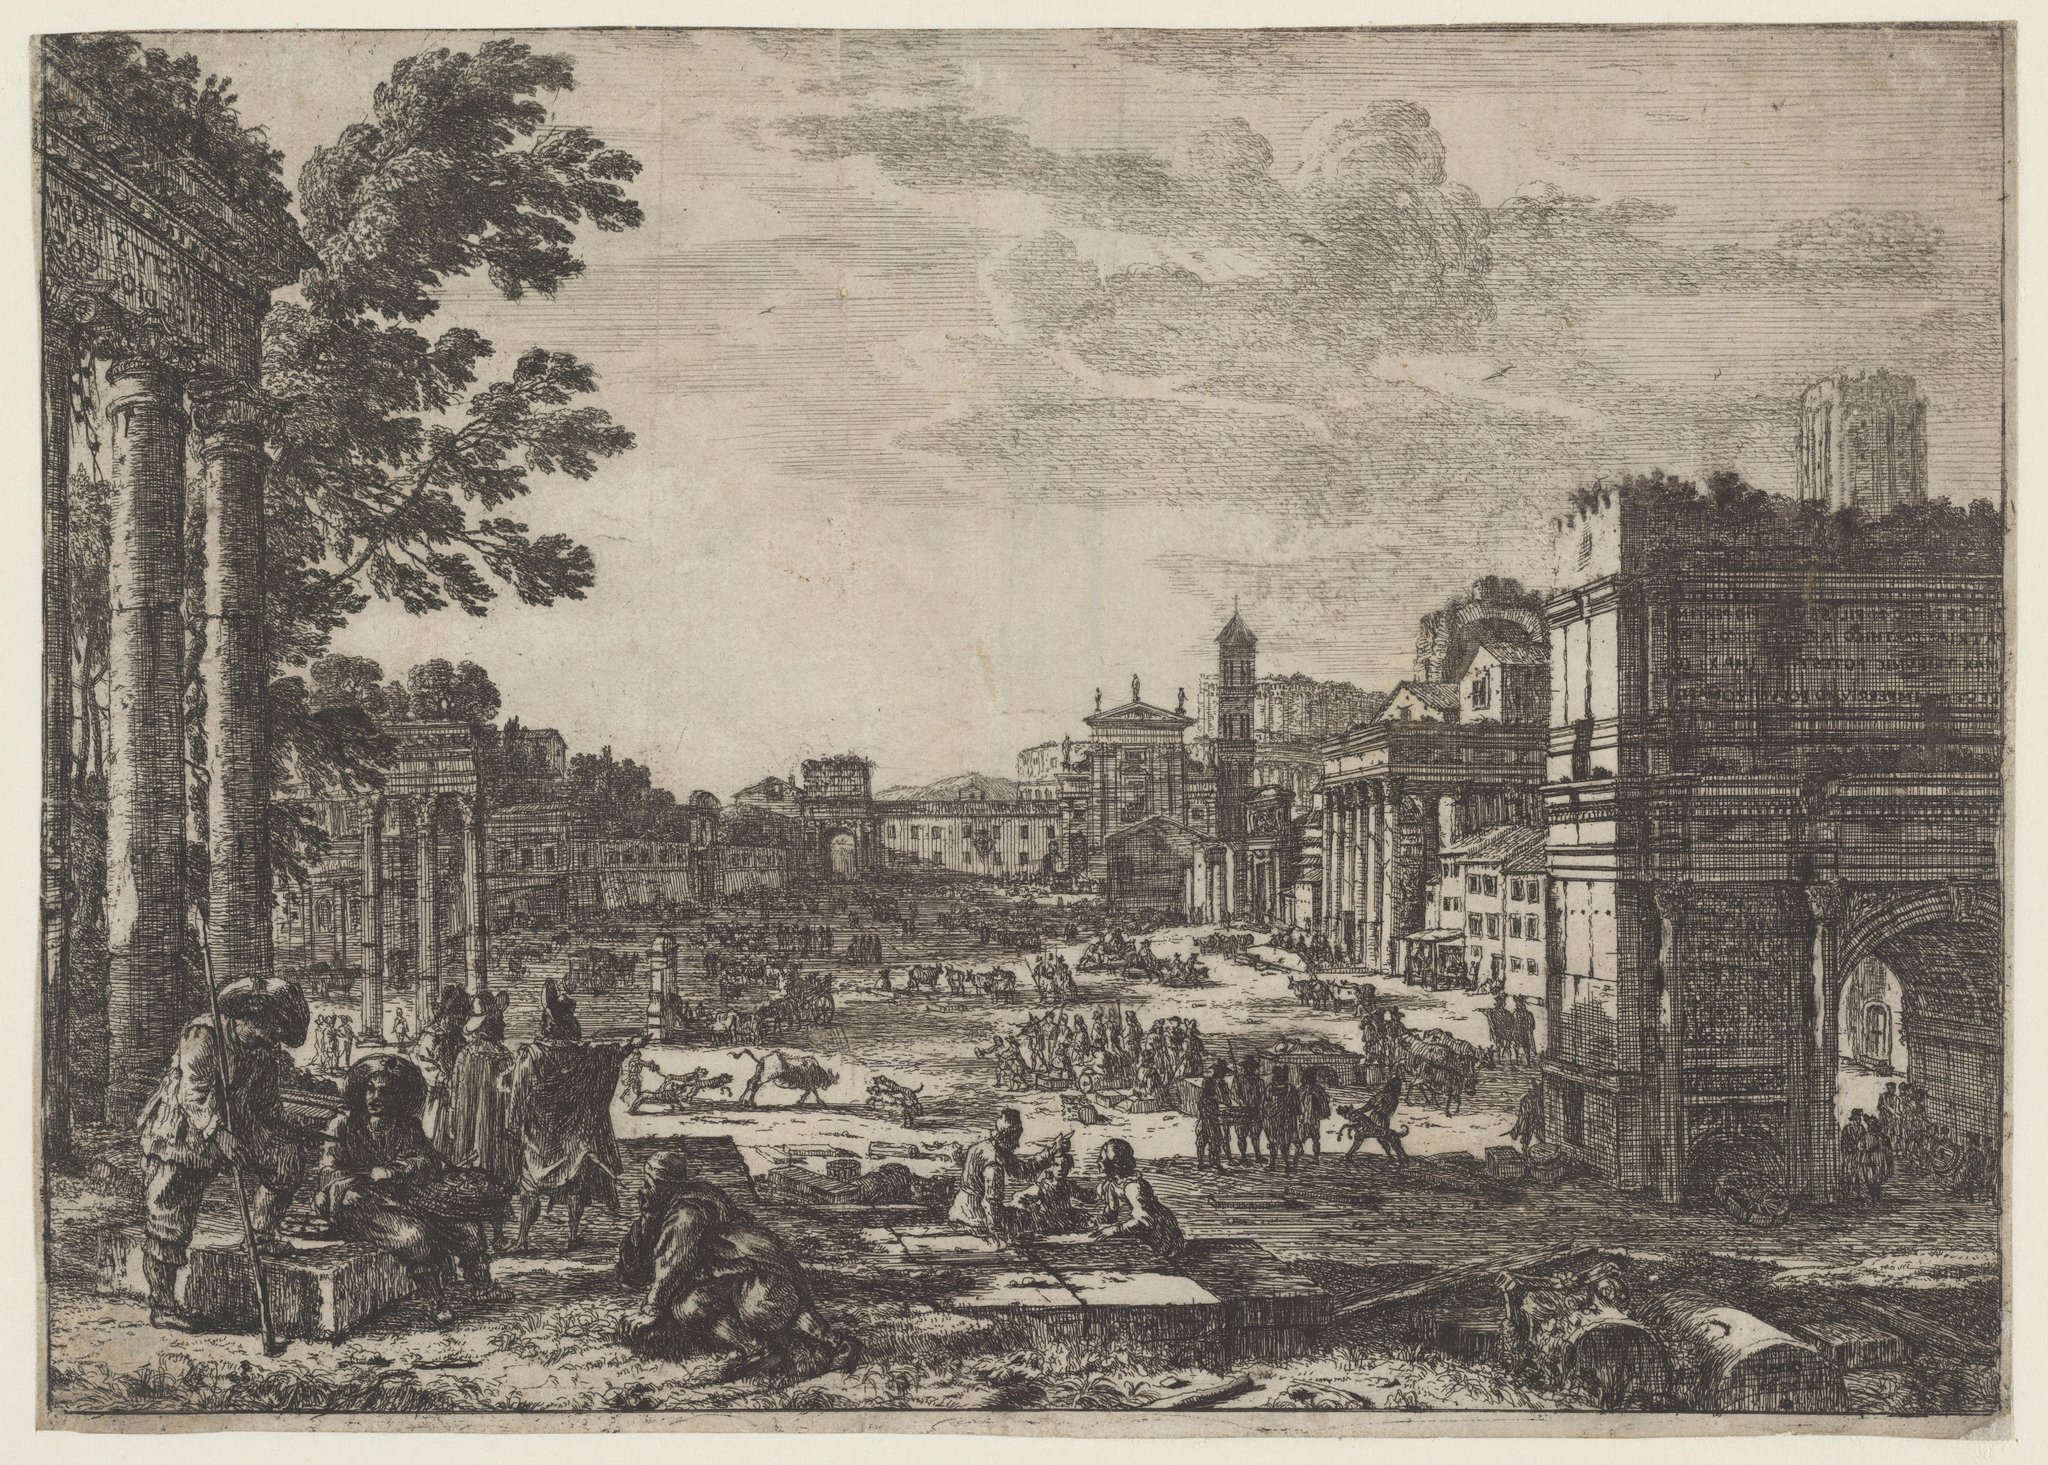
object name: print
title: Forum Romanum te Rome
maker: claude lorrain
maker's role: draughtsman, print maker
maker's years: 1604-1682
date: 1636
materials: paper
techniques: etching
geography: rome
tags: forum romanum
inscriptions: collector's mark: Lugt 2228, collector's mark: Lugt 132, collector's mark: Lugt 2760, collector's mark: Lugt 856, collector's mark: Lugt 1494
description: Gezicht op het forum in Rome met vele mensen. Uit de grond steken zuilen van tempels, rechts de boog van Septimius Severus. Op de voorgrond en op het veld zijn herders met hun koeien.